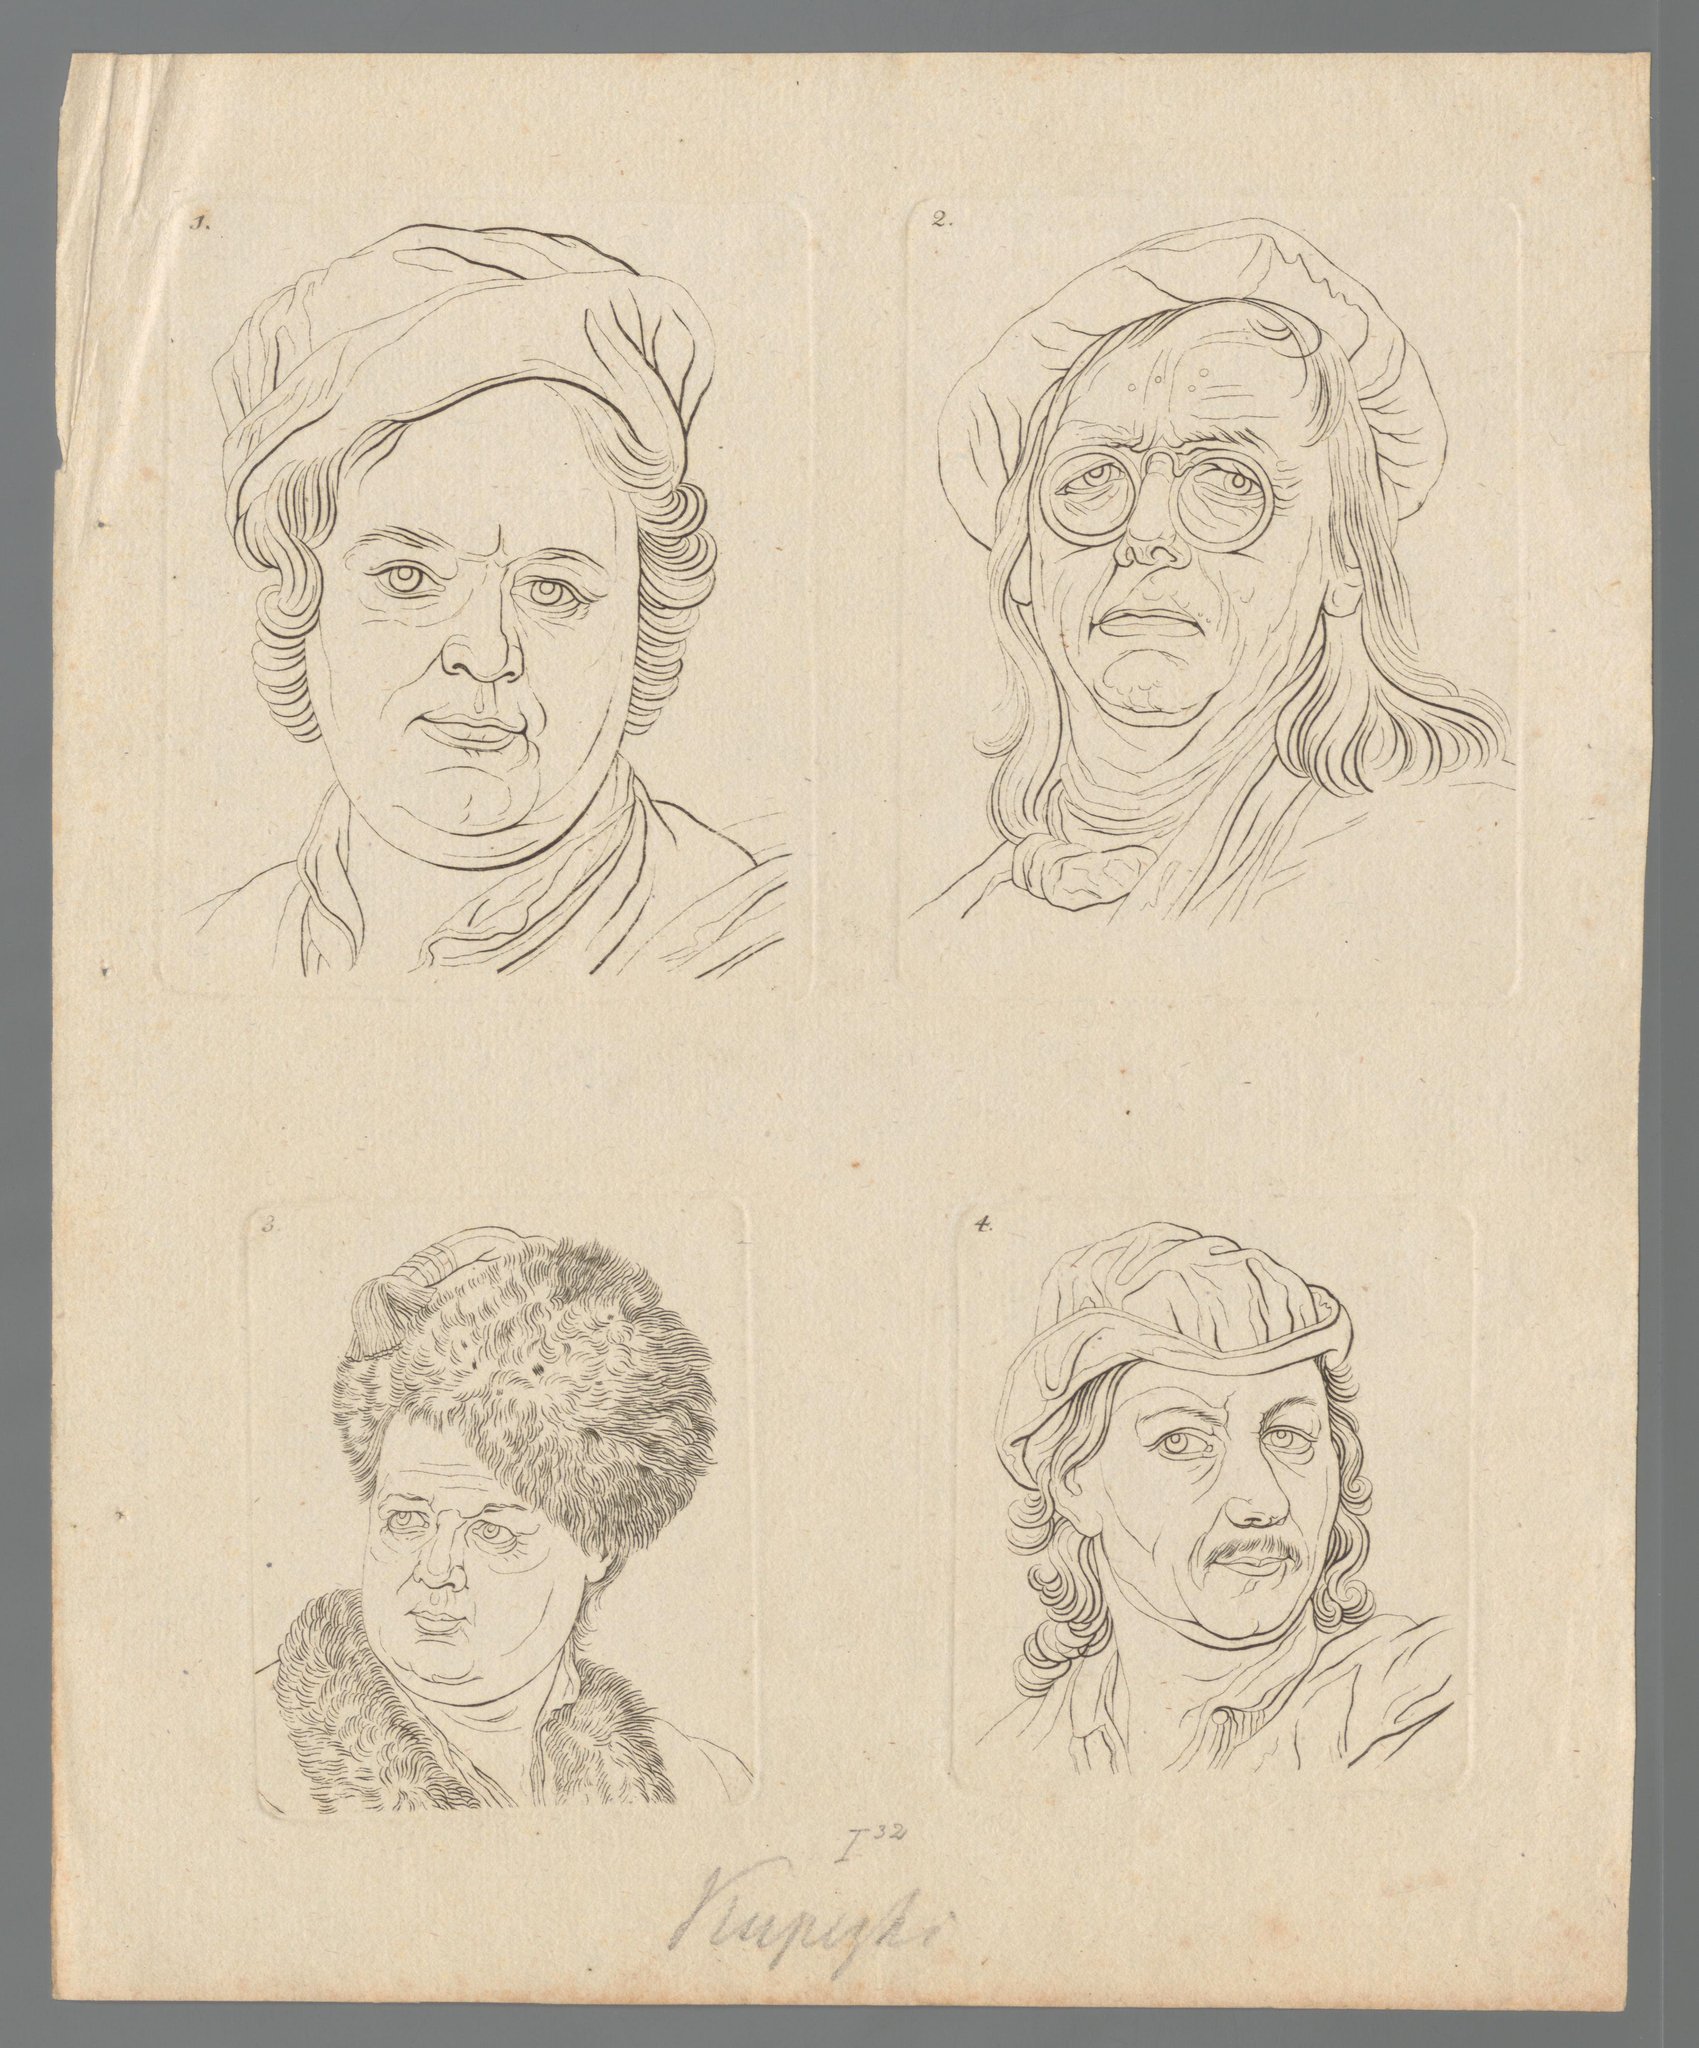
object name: print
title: Portretten van vier onbekende mannen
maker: Anonymous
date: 1800-1849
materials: paper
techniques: etching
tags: historical persons not known by name